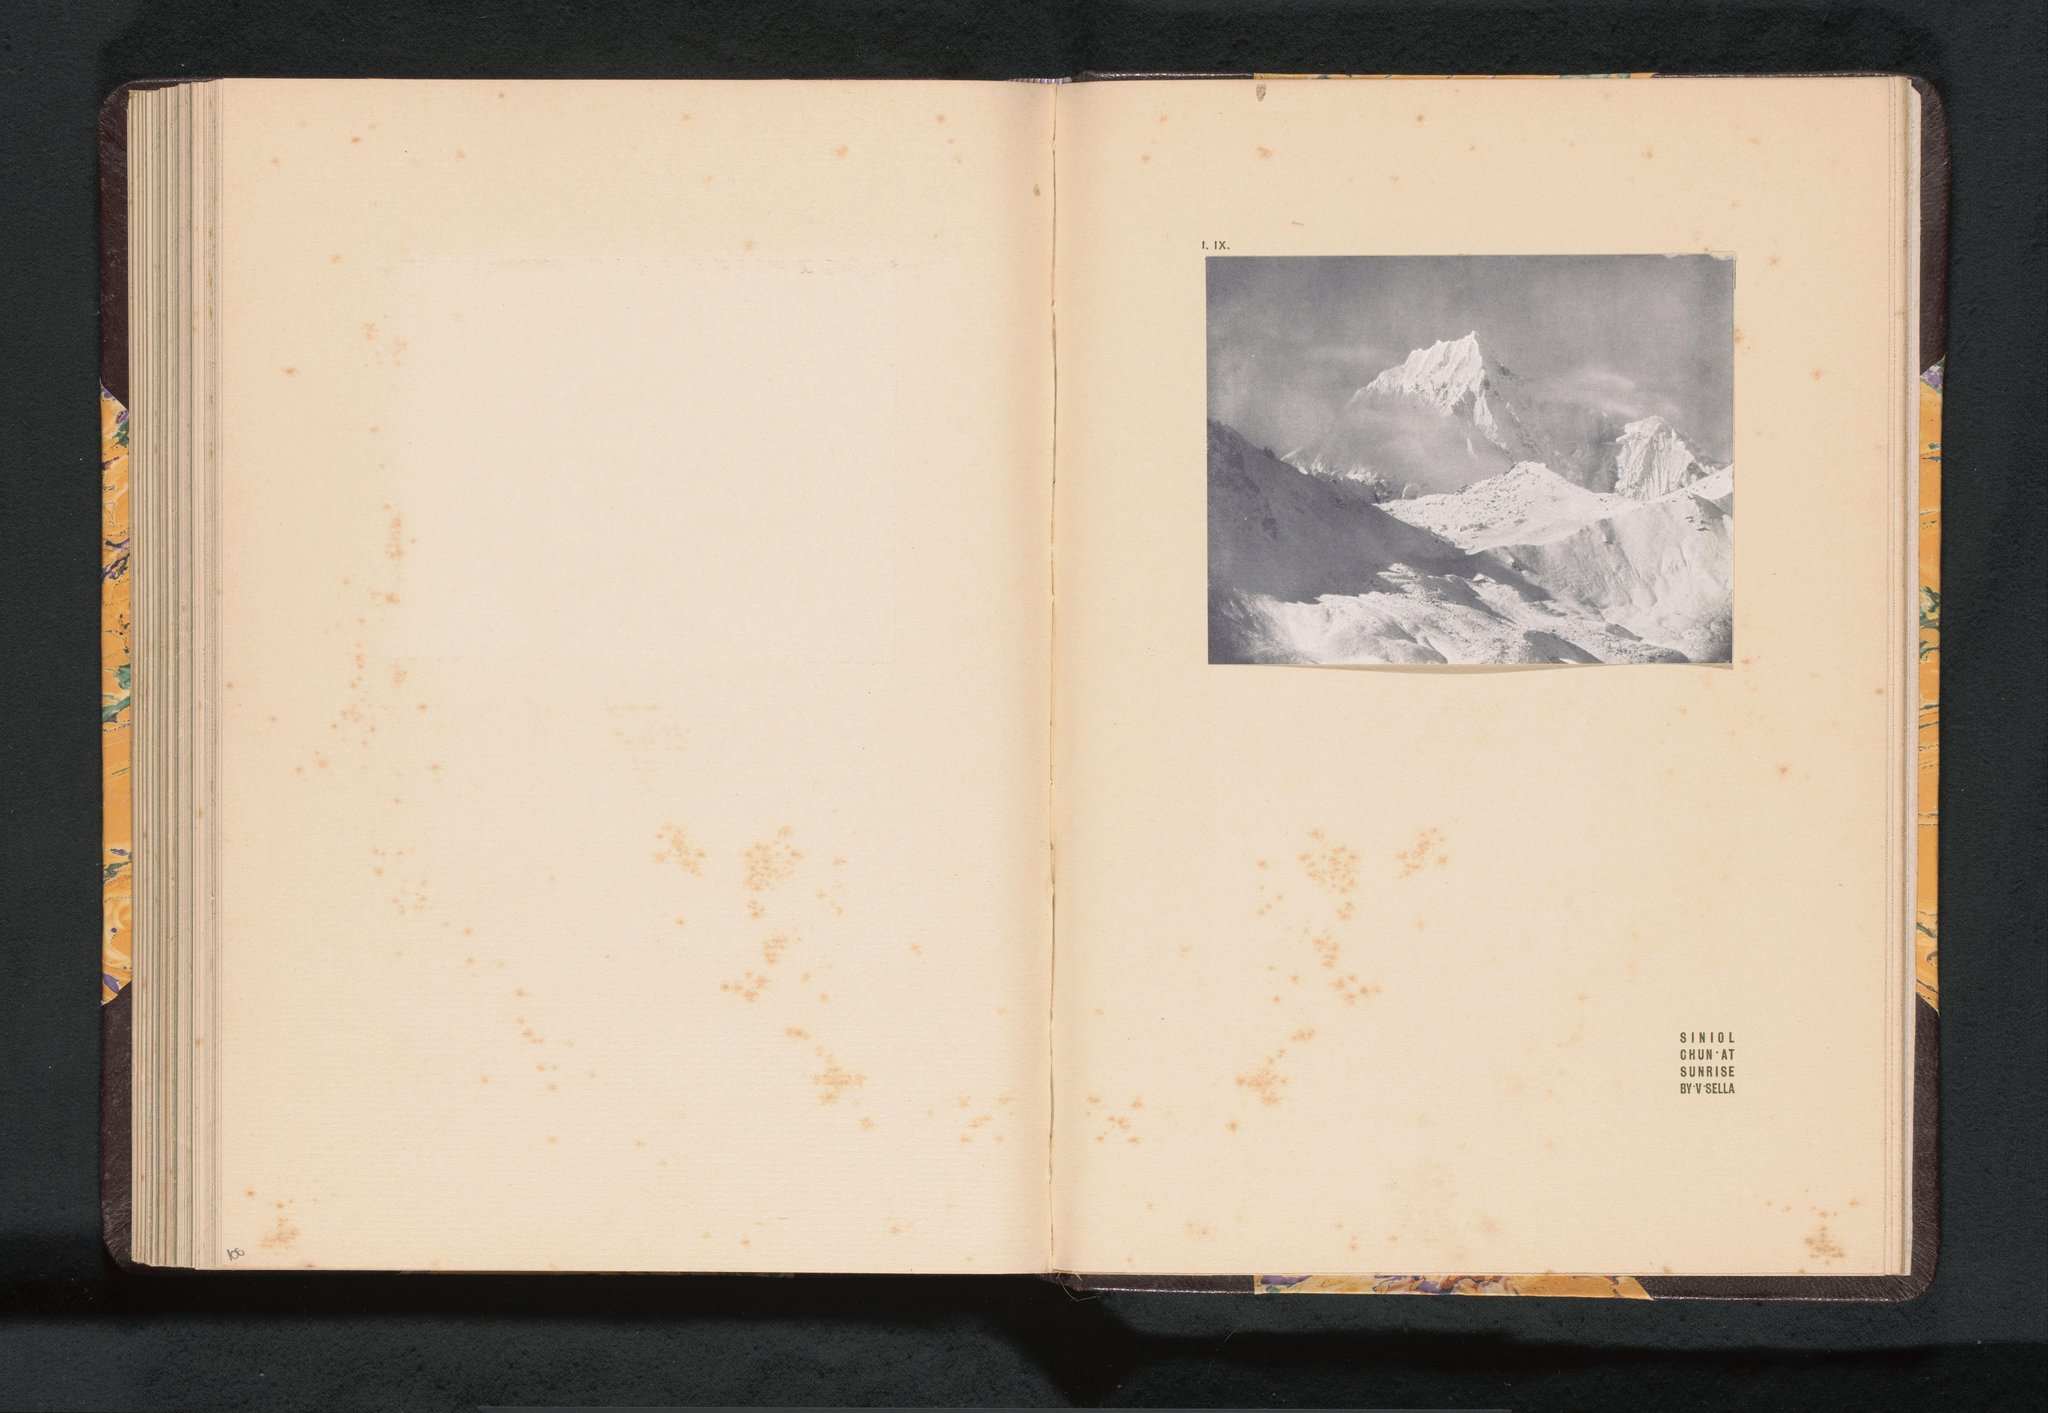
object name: page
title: Gezicht op de Siniolchu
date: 1900-1905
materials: paper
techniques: autotype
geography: india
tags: mountain-top, peak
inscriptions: inscription: ‘Siniolchun at sunrise by V. Sella’, inscription: ‘I. IX.’